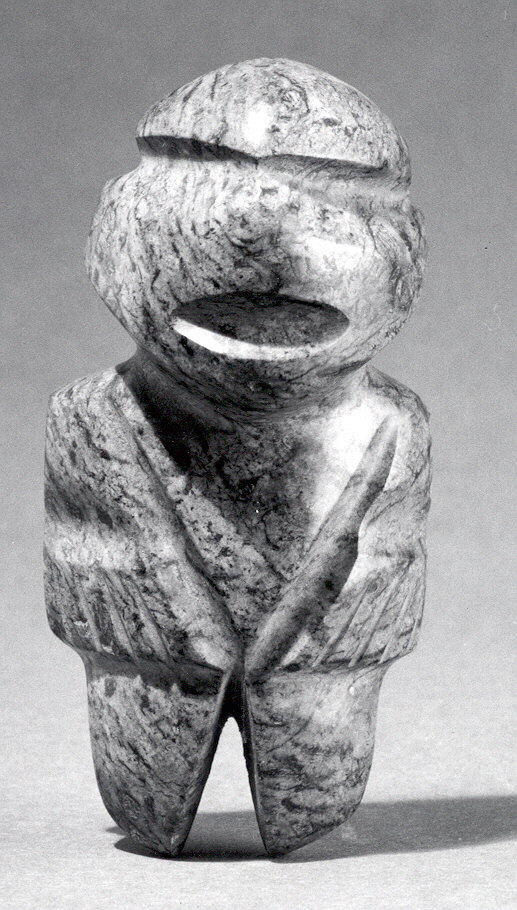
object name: male figure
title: Standing Figure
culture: mezcala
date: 1-800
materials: stone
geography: mexico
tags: human figures